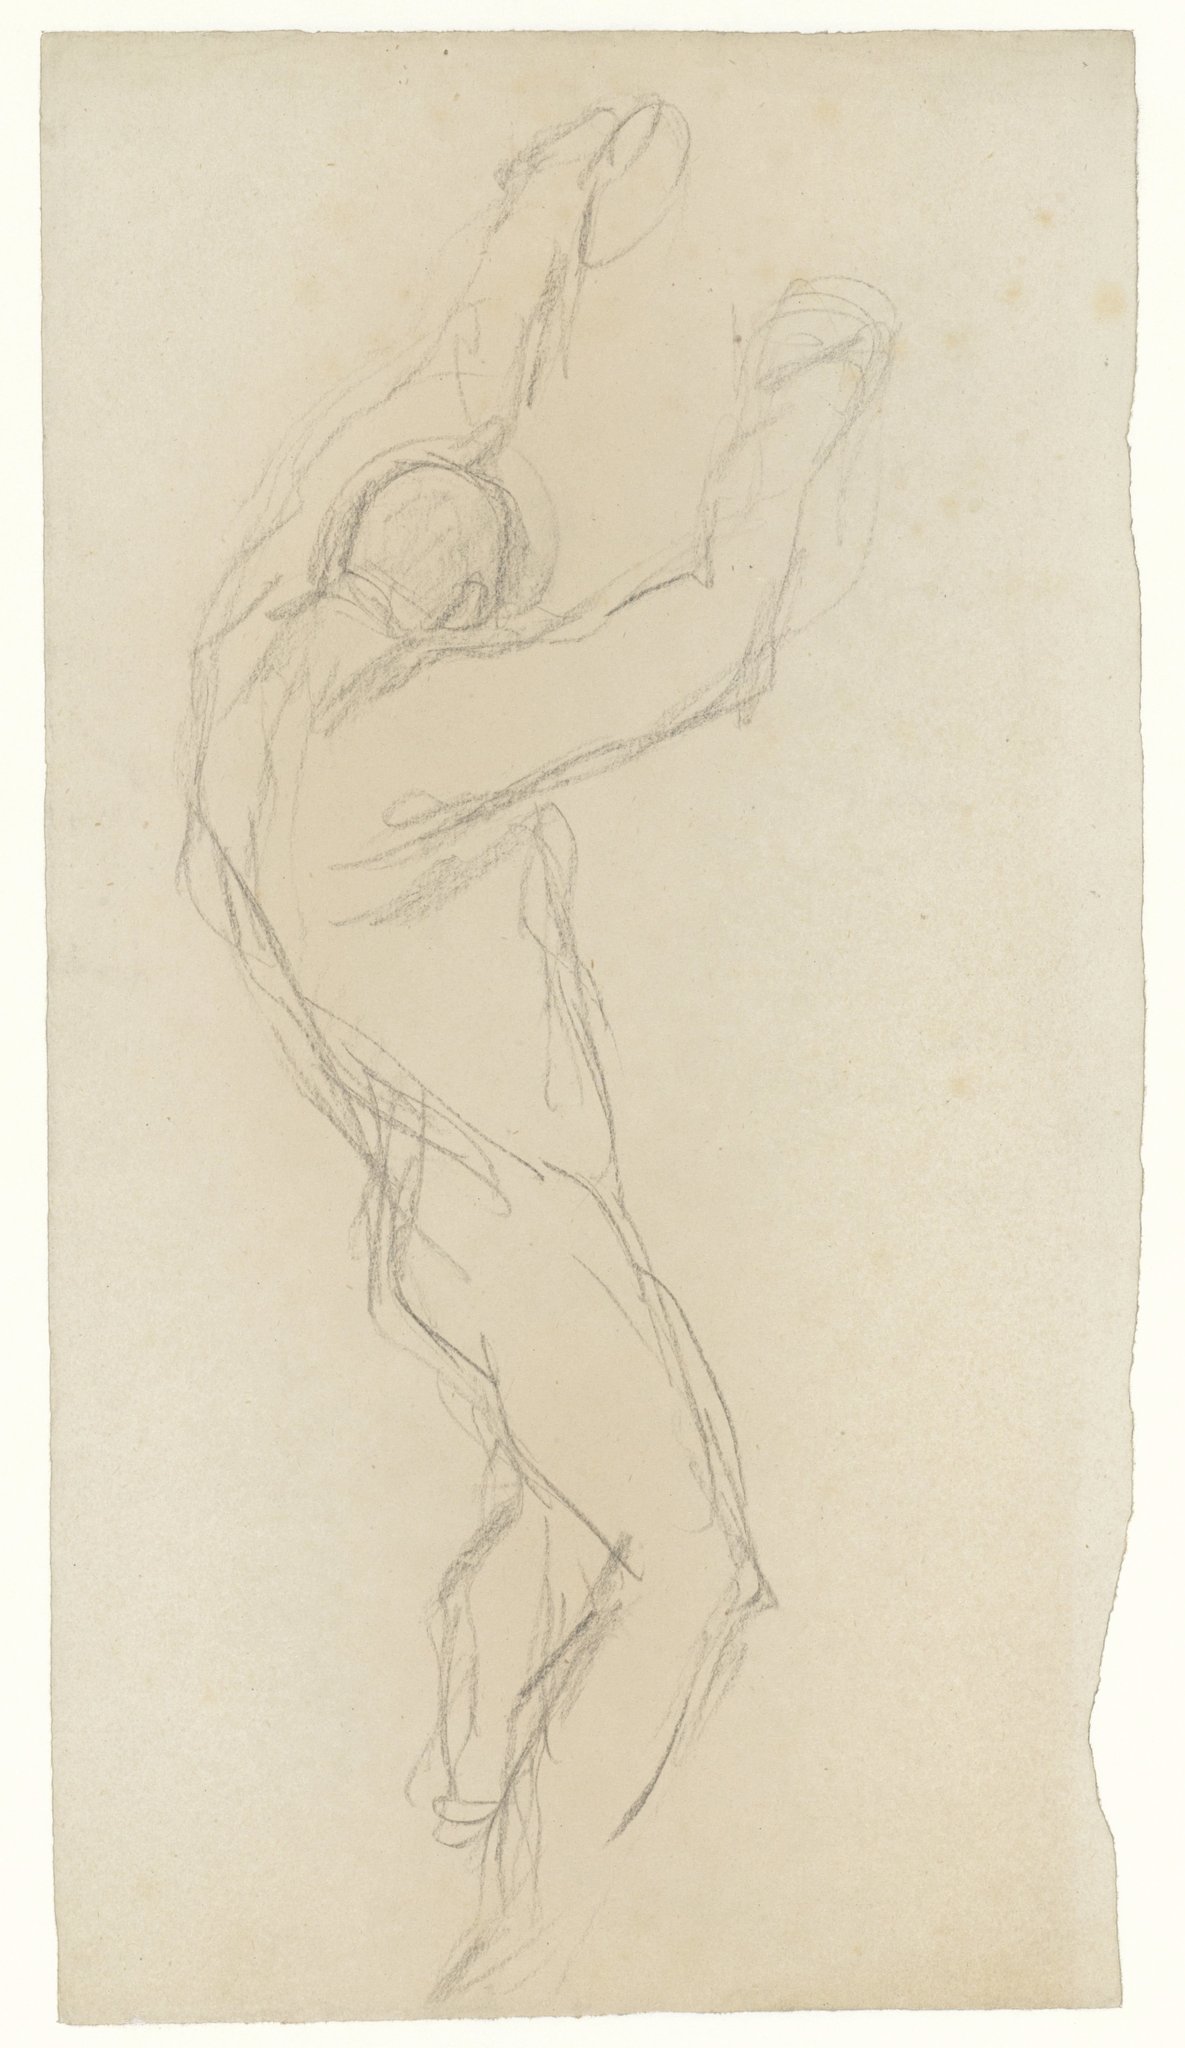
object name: drawing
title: Dansende figuur, naar rechts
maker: matthijs maris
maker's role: draughtsman, painter, print maker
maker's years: 1839-1917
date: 1849-1917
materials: chalk, paper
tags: ritual music and dancing ~ non-christian religions, dancing